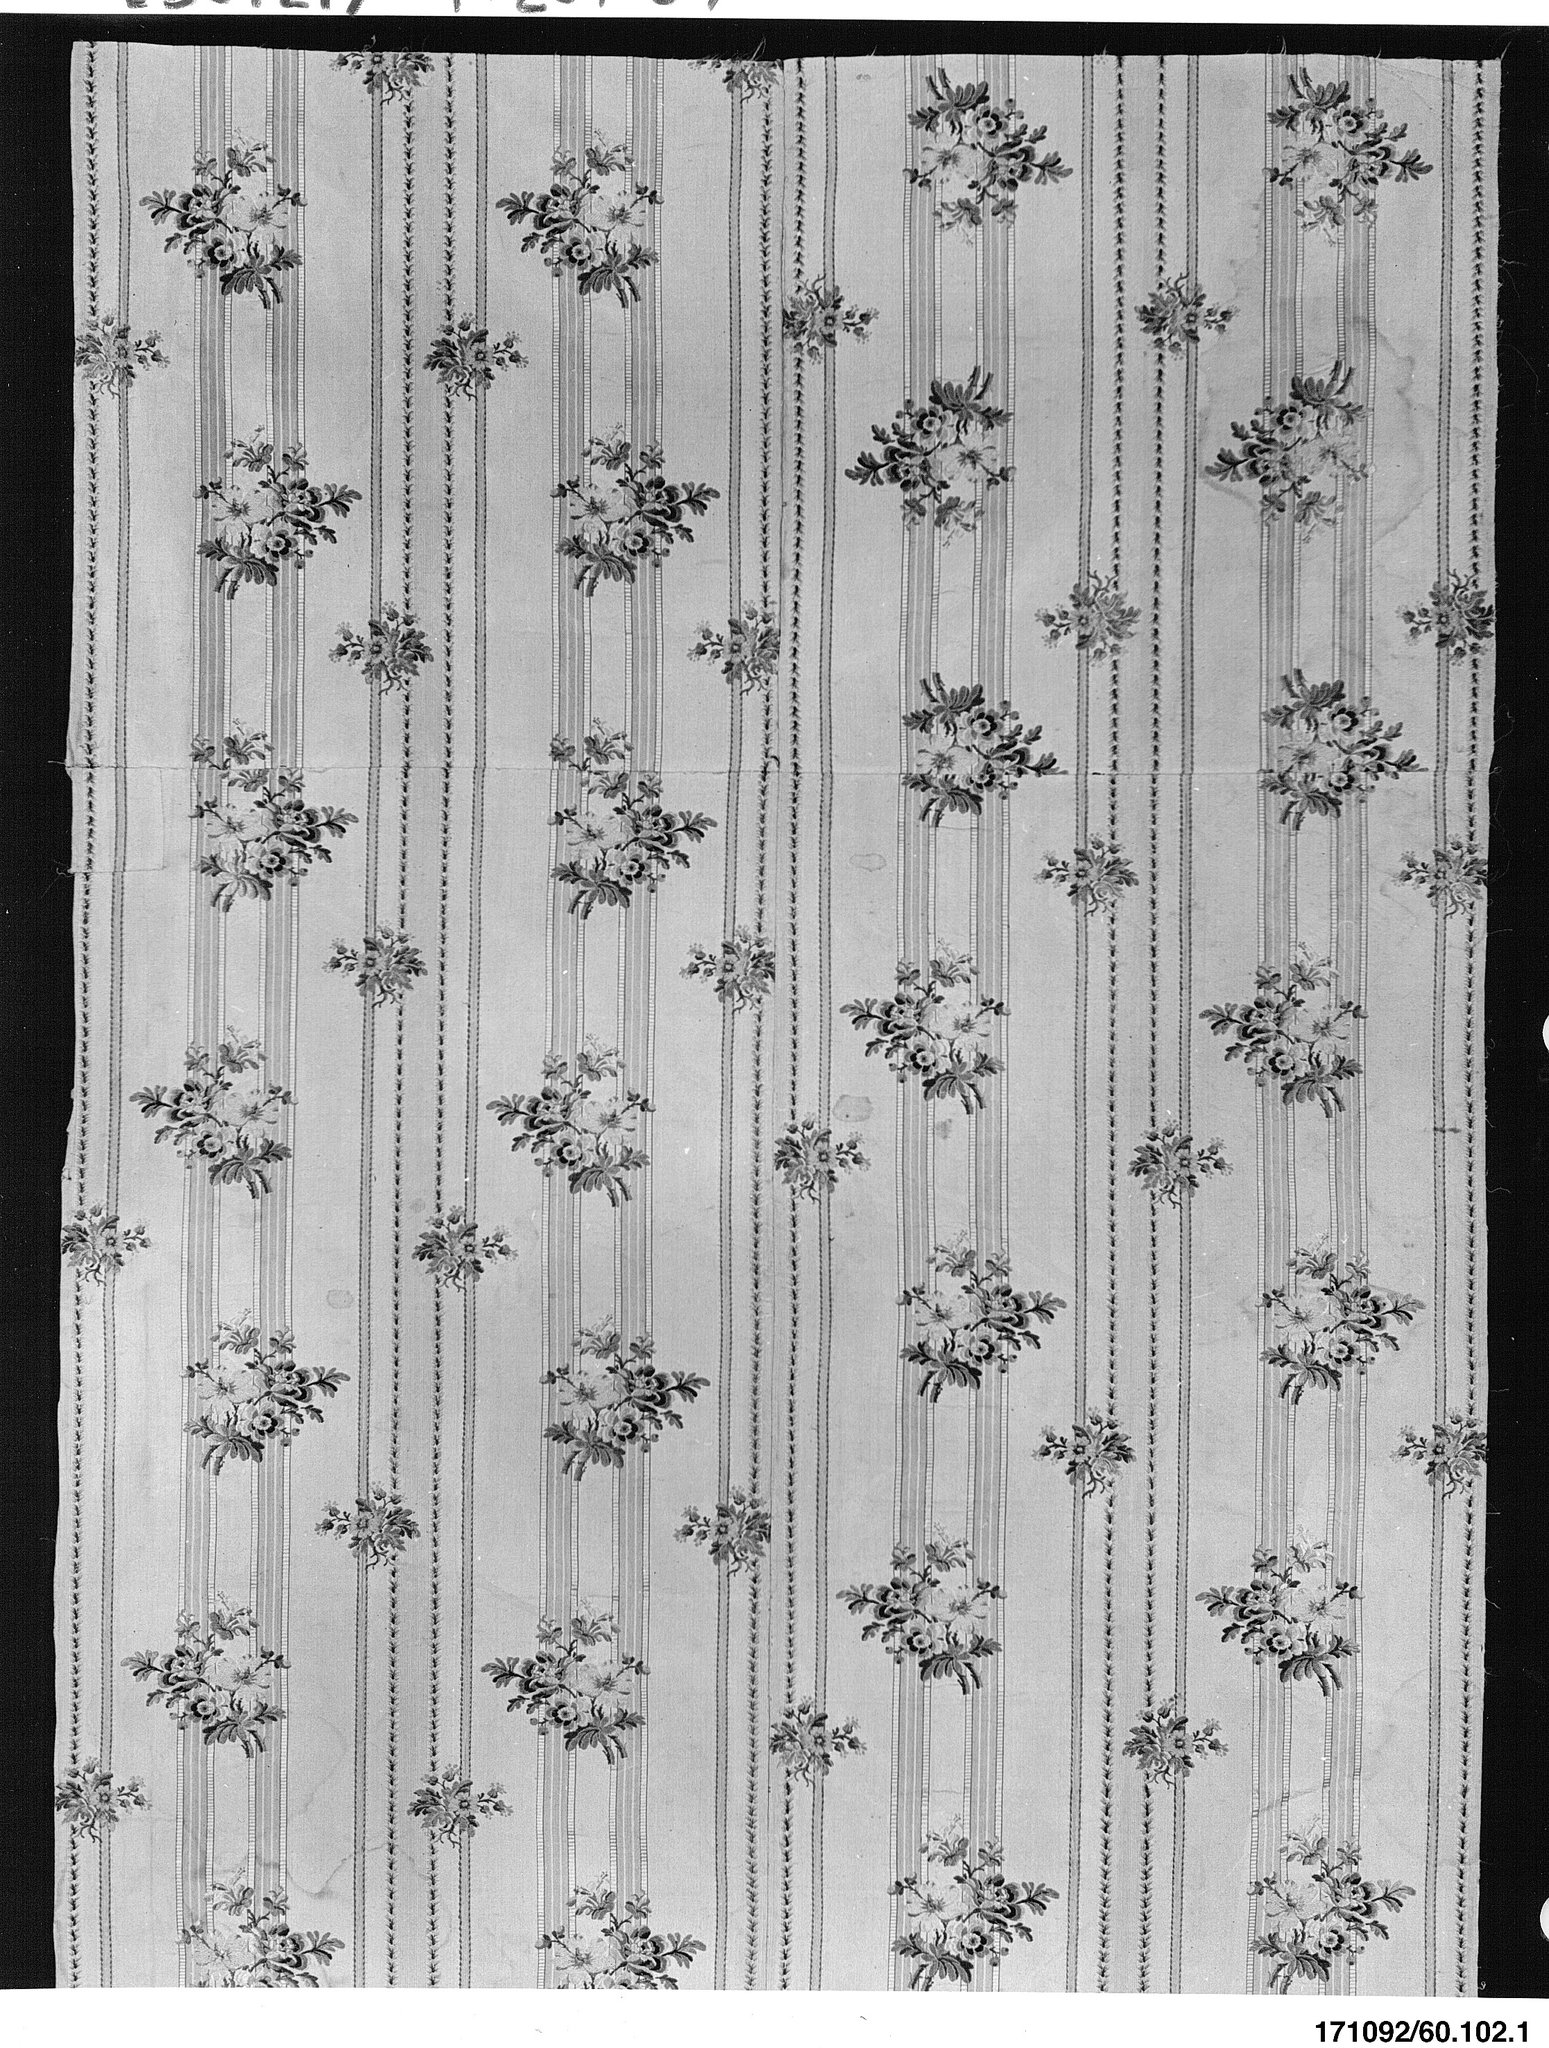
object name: piece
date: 1701-1800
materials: silk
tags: flowers,leaves